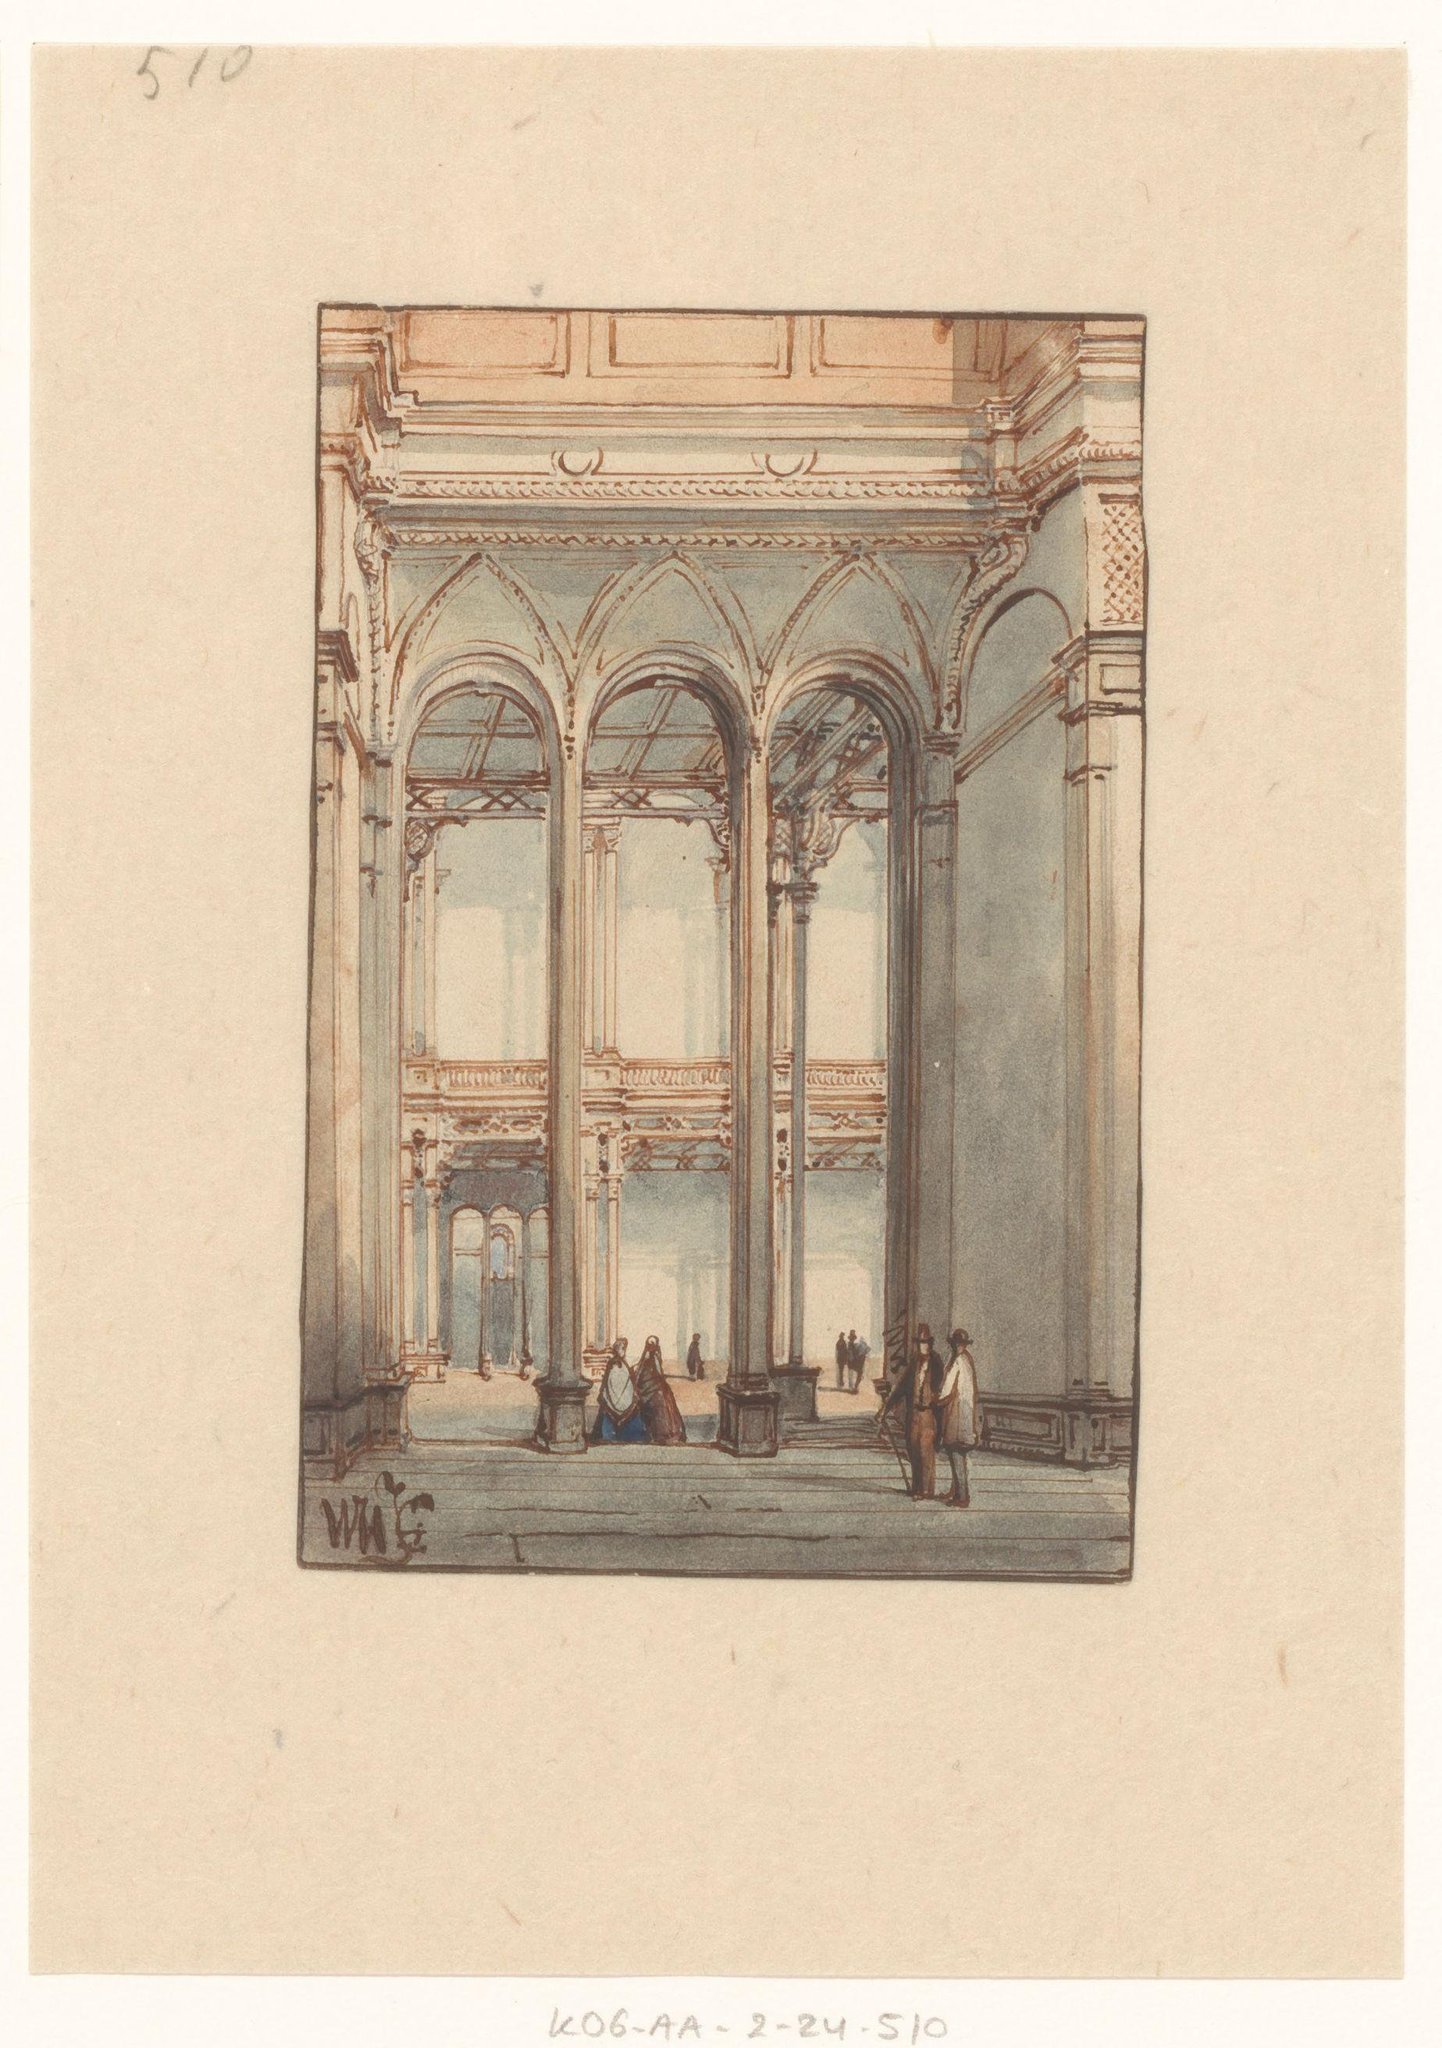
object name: drawing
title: Interieur van het Paleis voor Volksvlijt, gezien naar de Grote Zaal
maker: willem hekking jr.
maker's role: print maker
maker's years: 1825-1904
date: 1864-1904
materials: ink, paper, watercolor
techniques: brush, pen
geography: amsterdam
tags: permanent exhibition, museum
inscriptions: signature: ‘WHjr’, collector's mark: Lugt 800a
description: Tekening binnen de Atlas Van Eck ingedeeld op wijknummer 24.